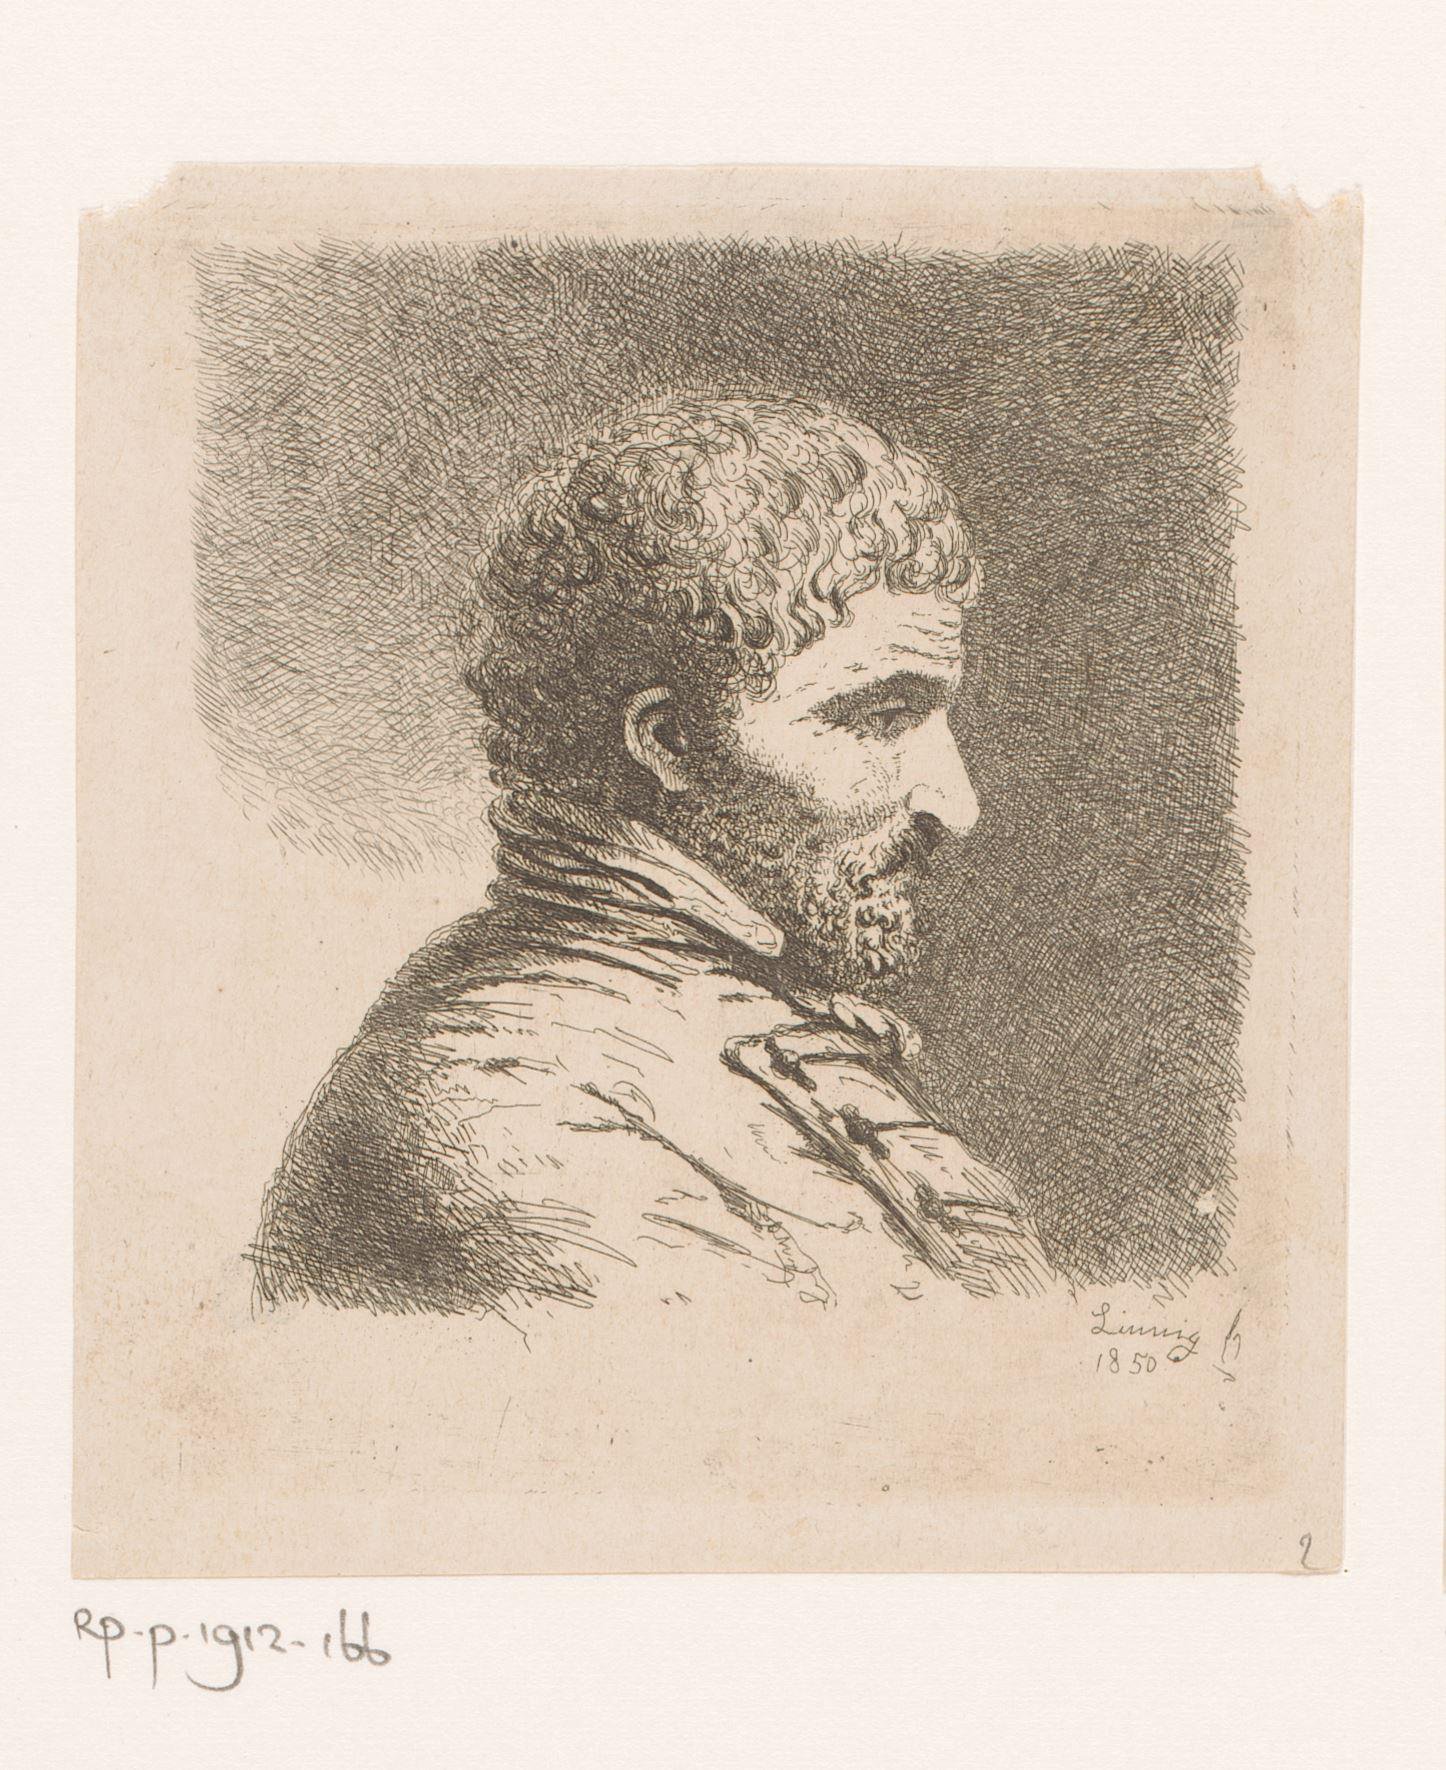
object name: print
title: Portret van een onbekende man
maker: jean théodore joseph linnig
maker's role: draughtsman, print maker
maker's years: 1815-1891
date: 1850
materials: paper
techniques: etching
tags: anonymous historical person portrayed alone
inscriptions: collector's mark: Lugt 2228, collector's mark: Lugt 1485